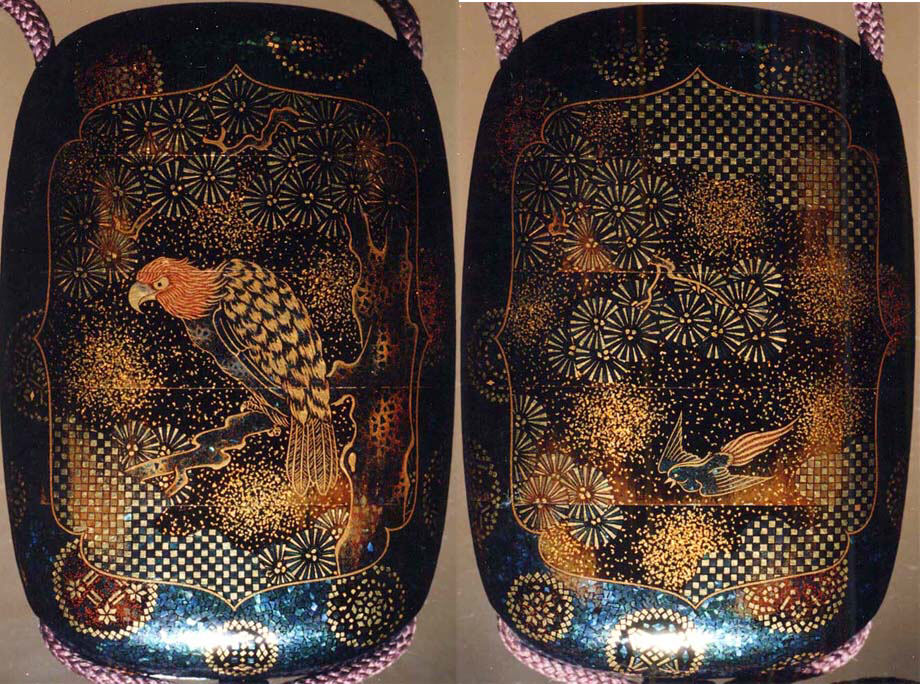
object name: inrō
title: Case (Inrō) with Design of Perched Hawk in Pine Tree (obverse); Small Bird in Flight (reverse)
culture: japanese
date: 1801-1900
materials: gold, lacquer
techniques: fundame, roiro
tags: birds,hawks,trees